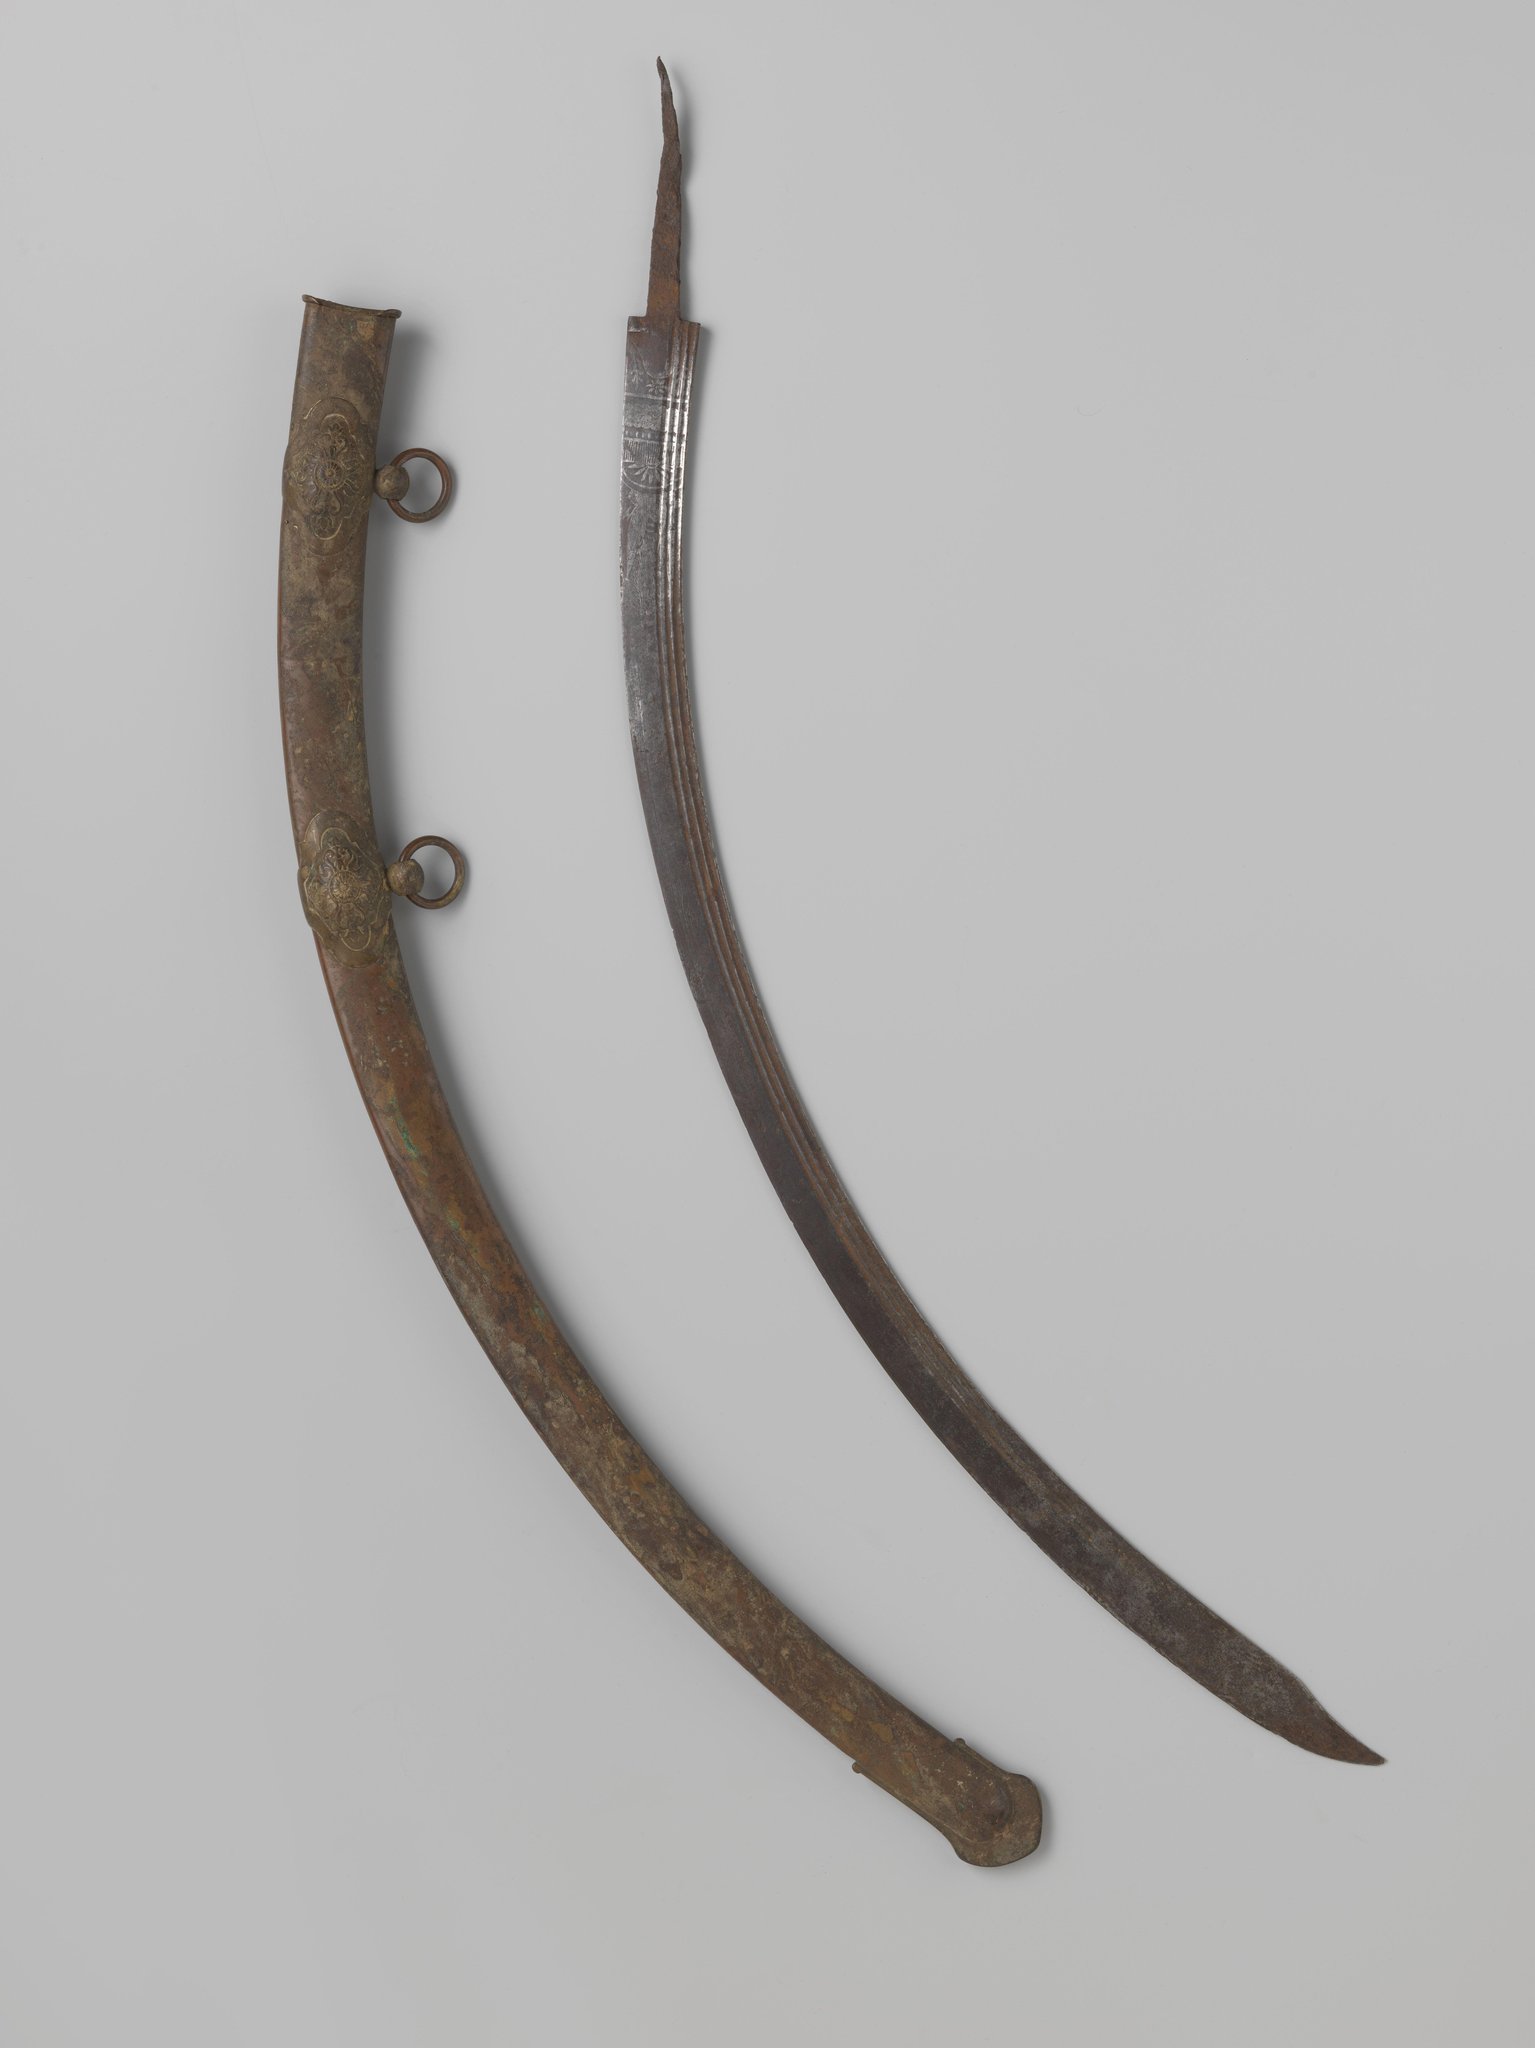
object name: sabre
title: Frans cavaleriesabel met schede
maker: Anonymous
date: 1800-1950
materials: iron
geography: france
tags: france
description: Frans cavaleriesabel of Mamelukkensabel, zonder gevest.